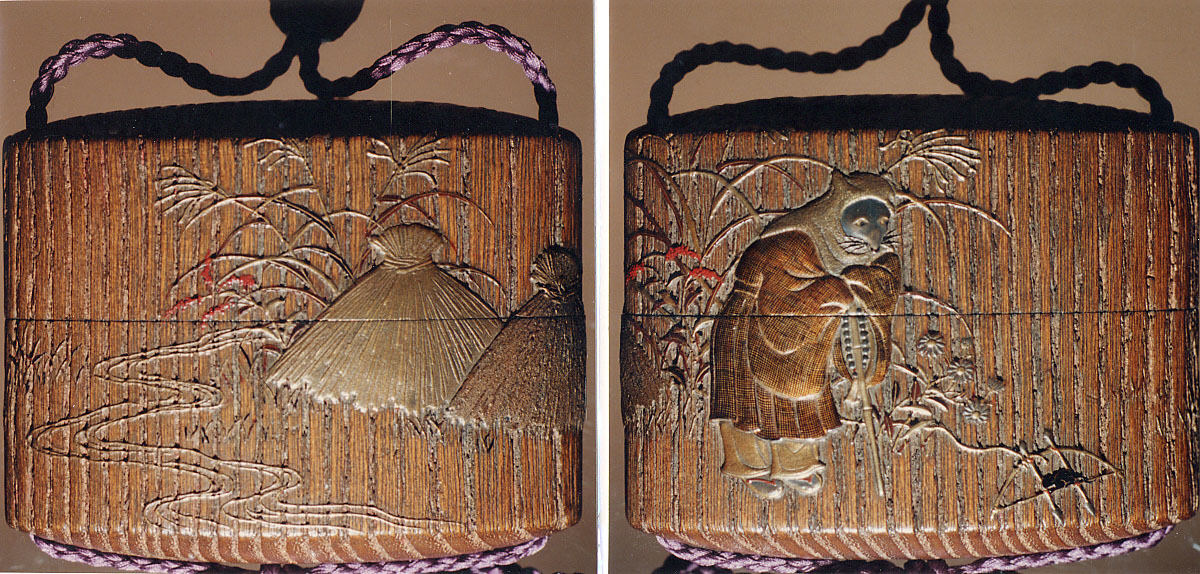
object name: inrō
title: Case (Inrō) with a Fox from the Kyōgen Play "The Fox Hunter" (Tsurigitsune) (obverse); Haystacks and Stream from the Kyōgen Play "Hakuzosu" (reverse)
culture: japanese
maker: shibata zeshin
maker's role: artist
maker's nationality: japanese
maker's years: 1807-1891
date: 1801-1900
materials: ceramic, gold, lacquer, wood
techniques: carving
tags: foxes,haystacks